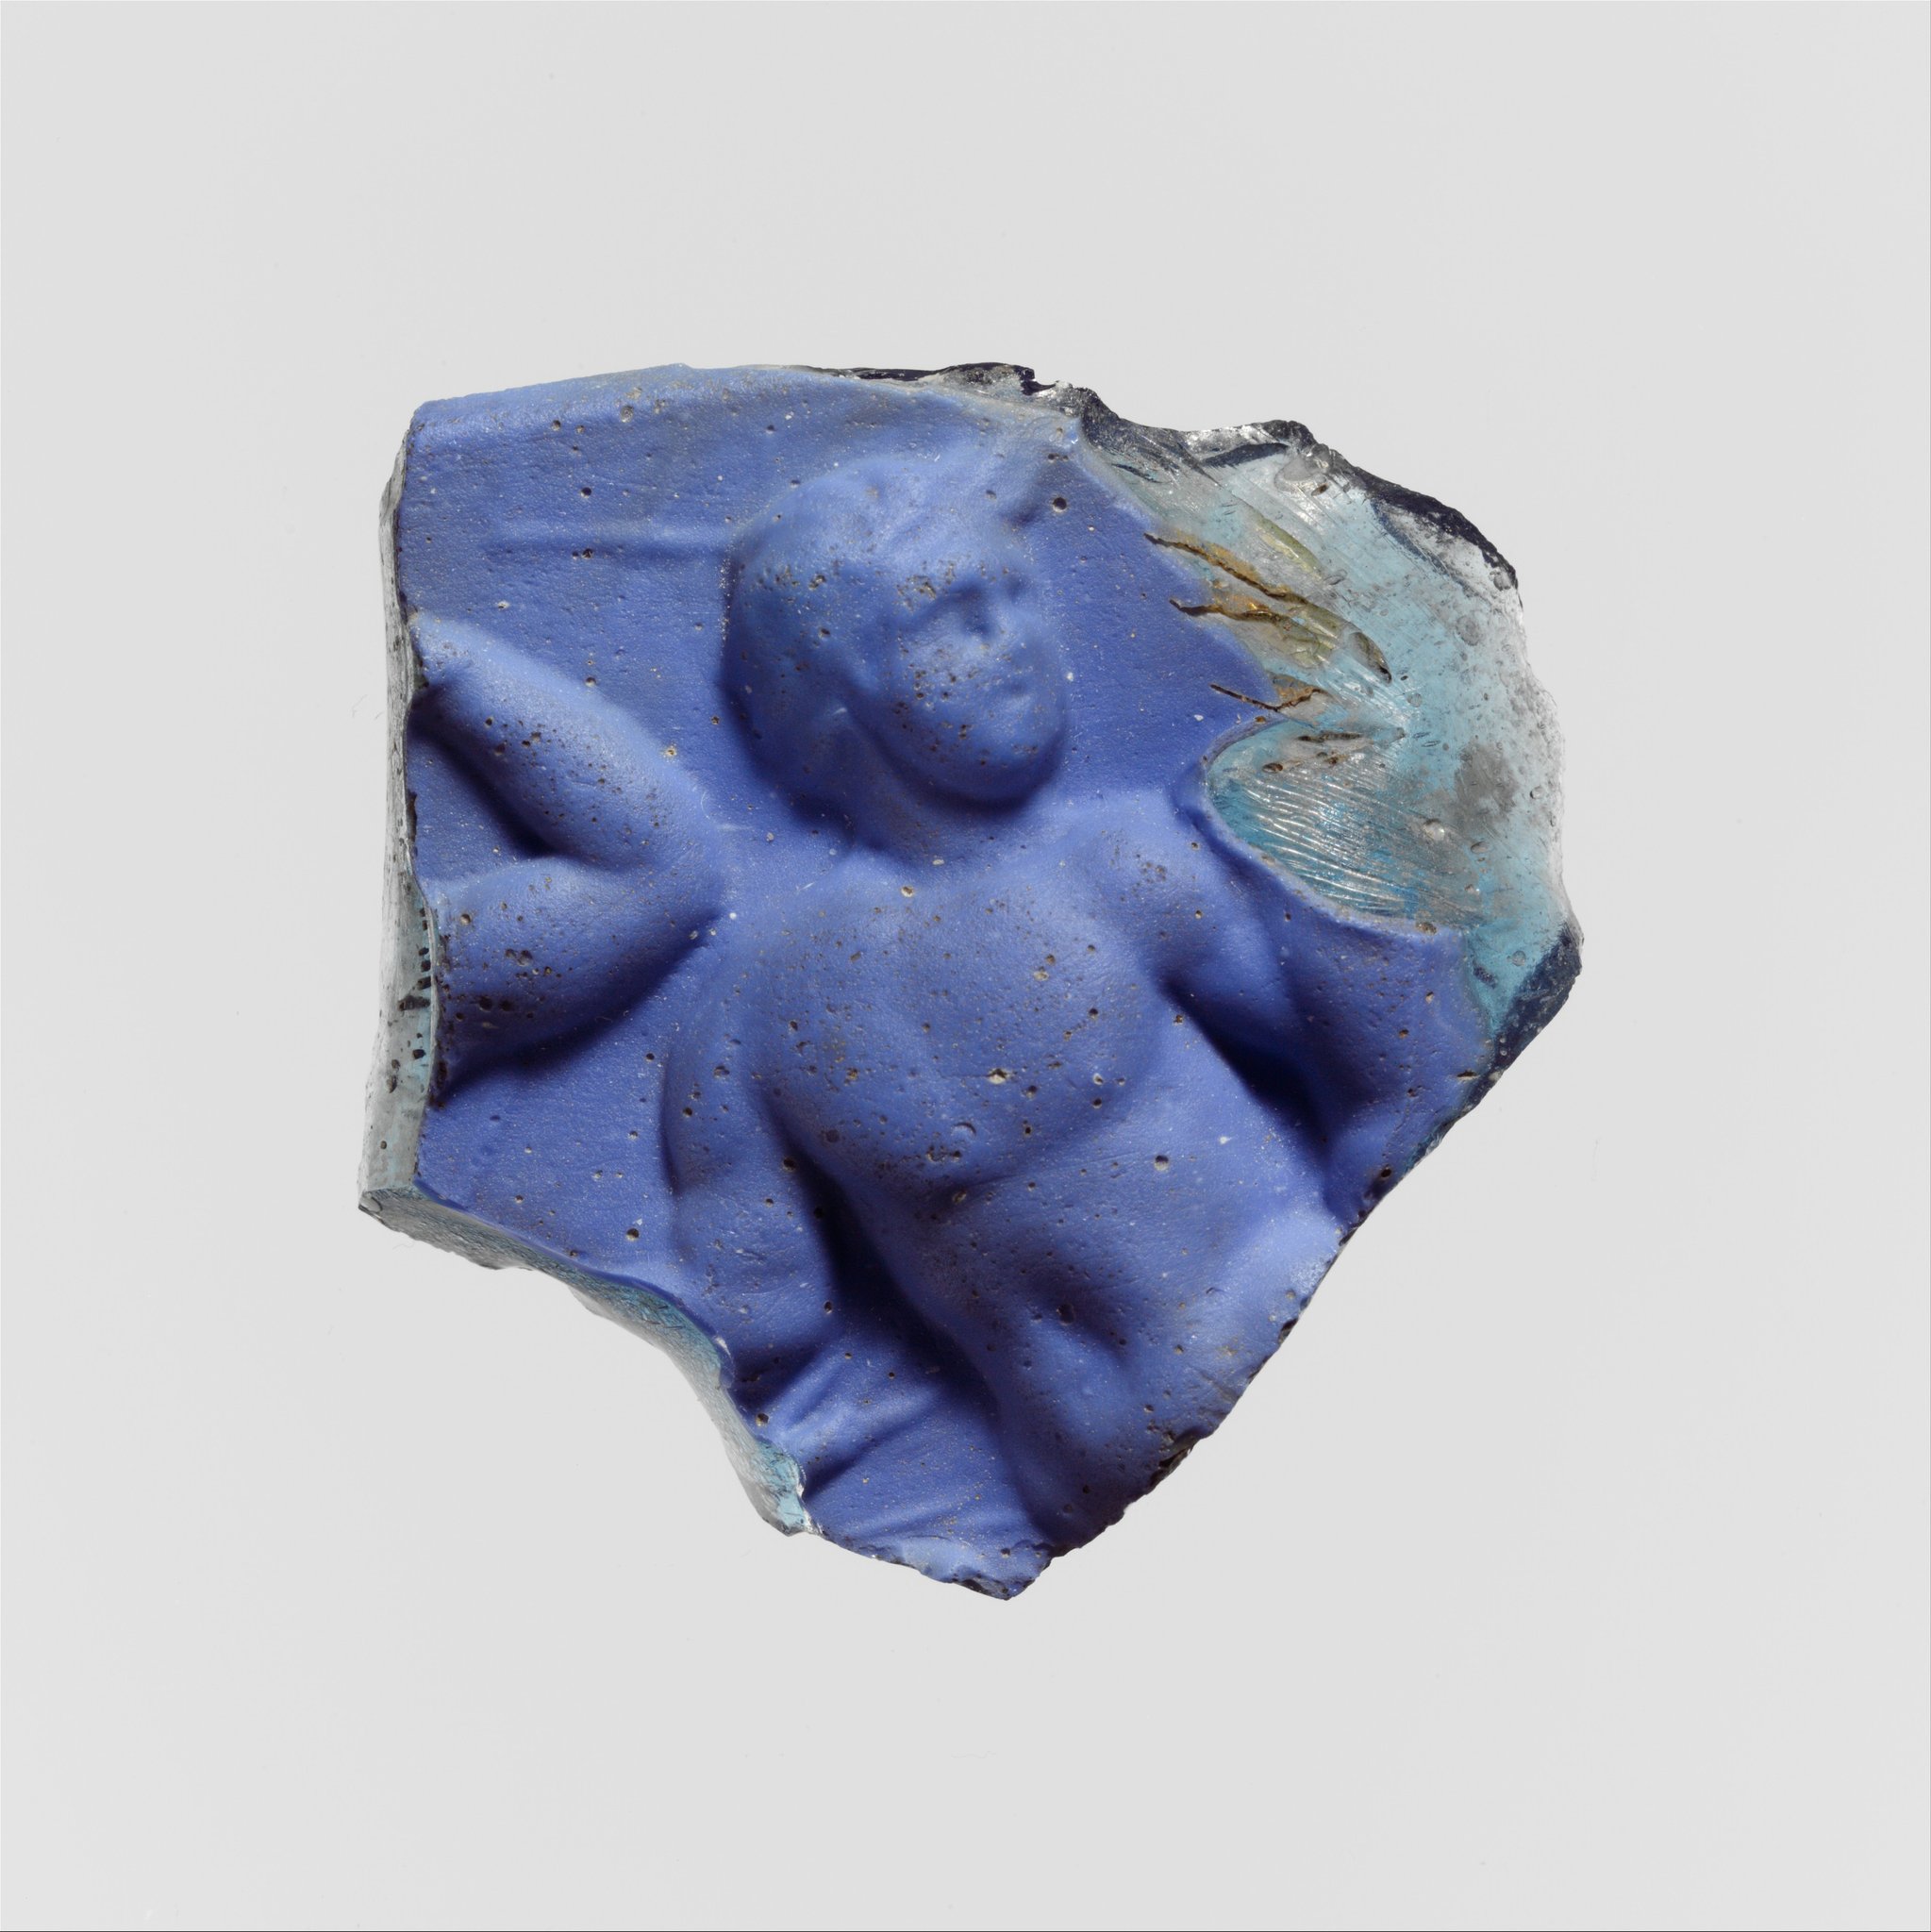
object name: plaque fragment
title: Glass plaque fragment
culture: roman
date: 1-100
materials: glass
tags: men